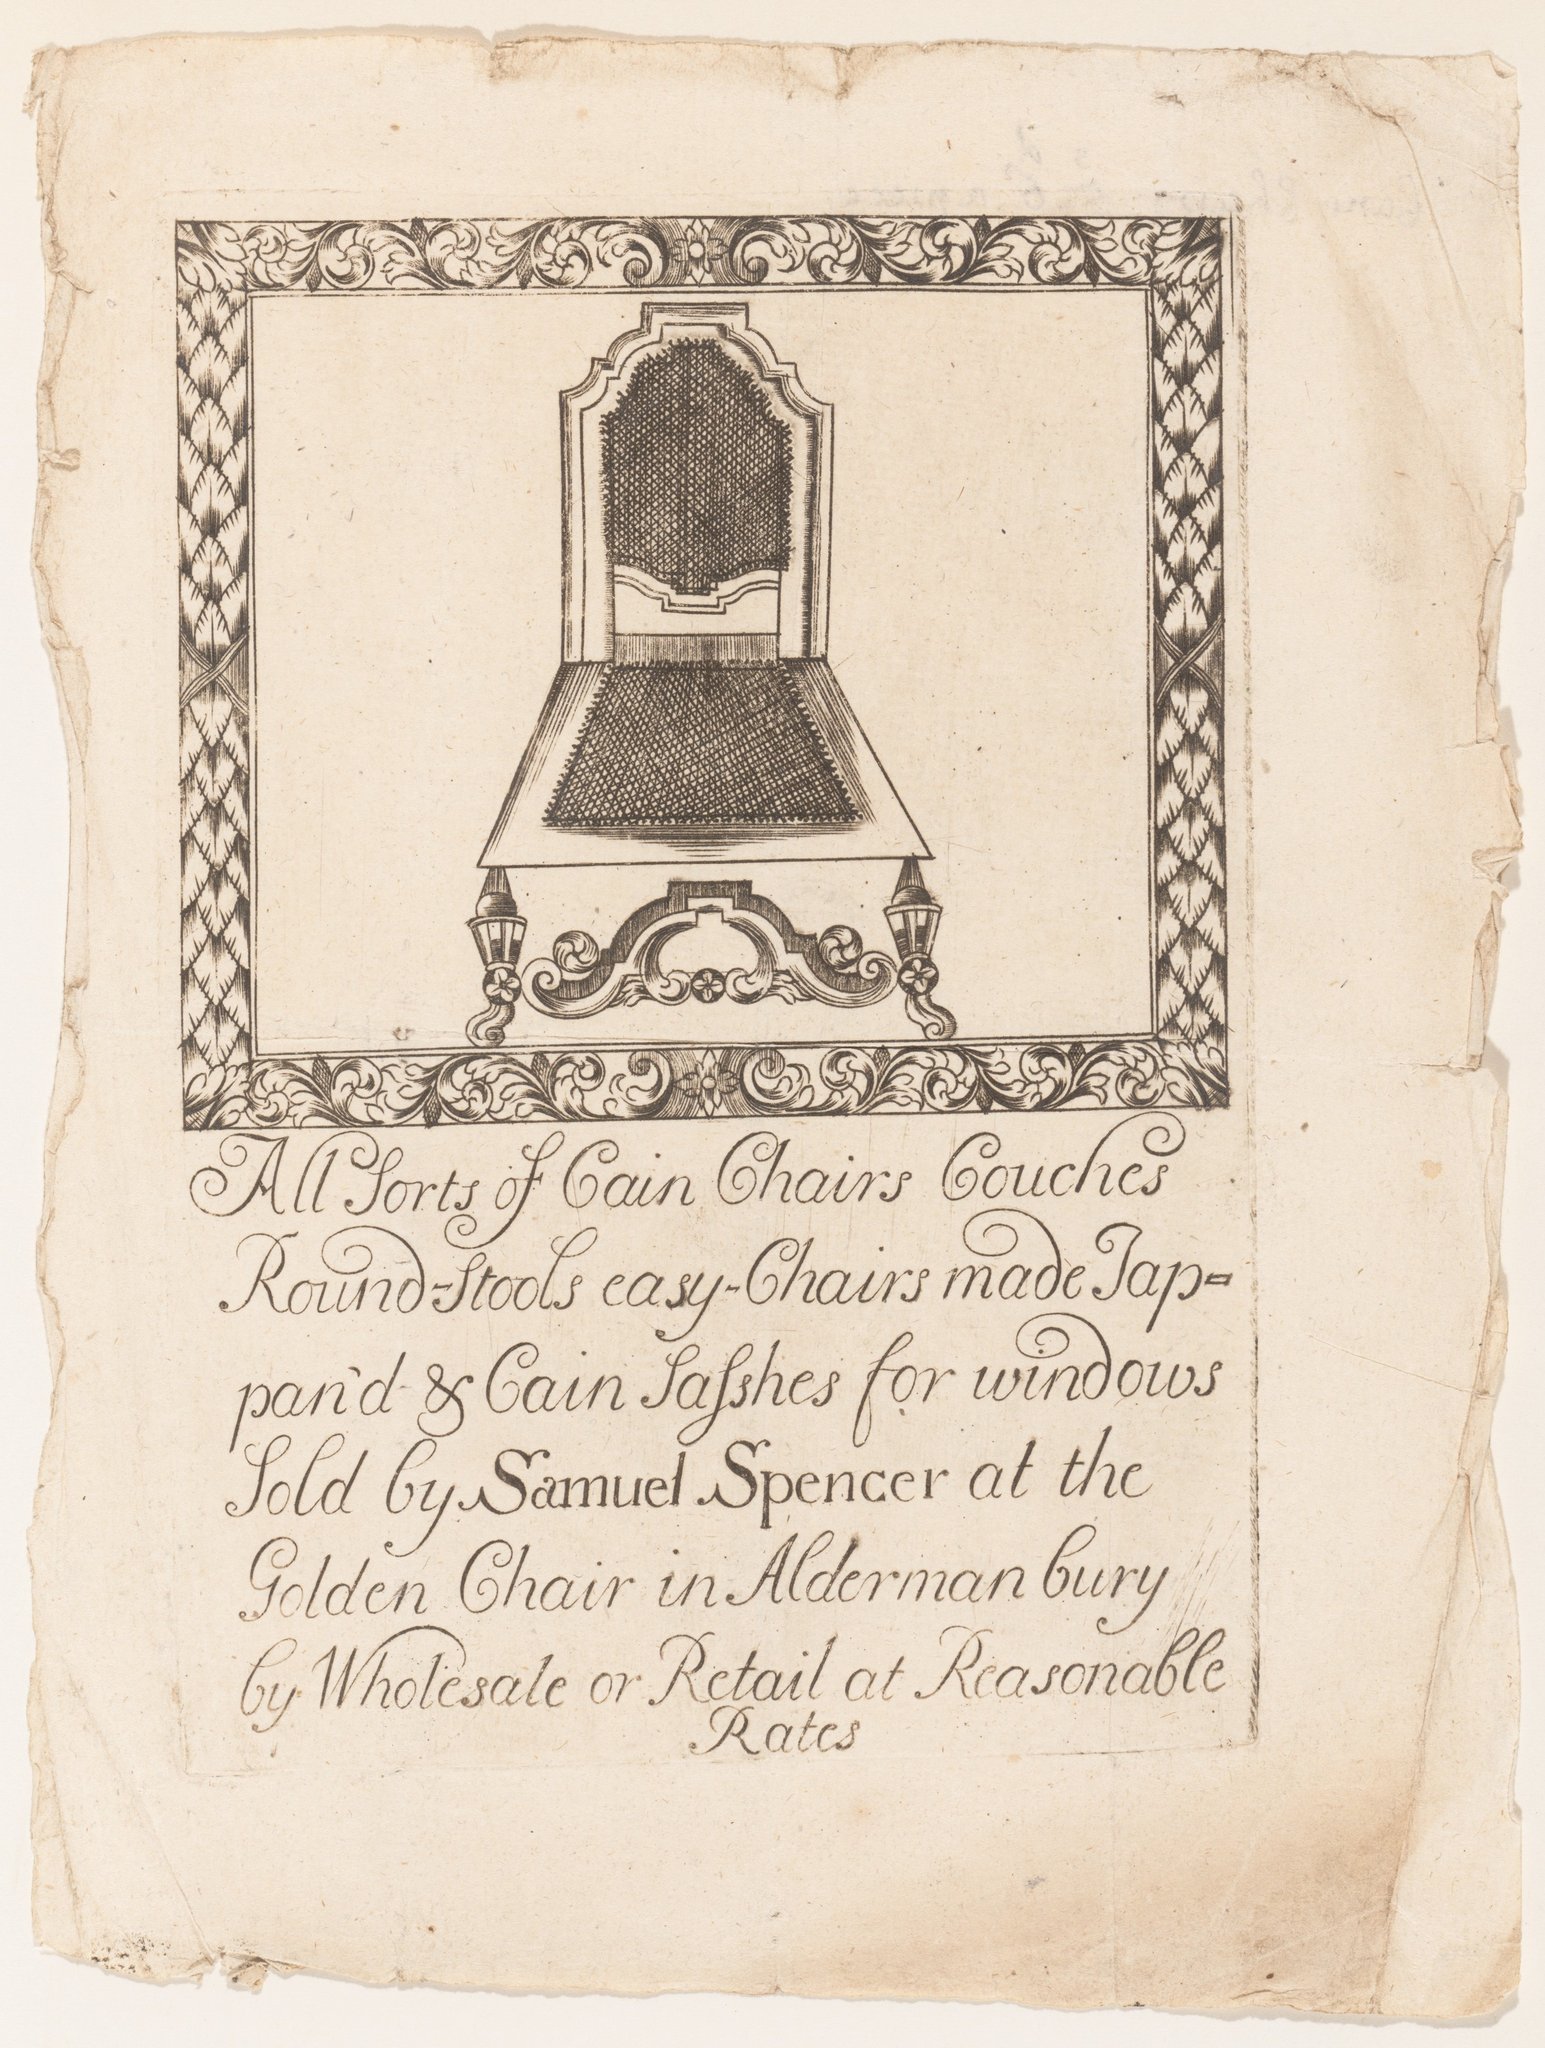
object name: print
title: Trade Card of Samuel Spencer, Cain Chairs, at the Golden Chair in Aldermanbury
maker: samuel spencer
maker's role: artist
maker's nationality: british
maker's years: 1650-1750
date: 1700-1720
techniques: engraving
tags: chairs